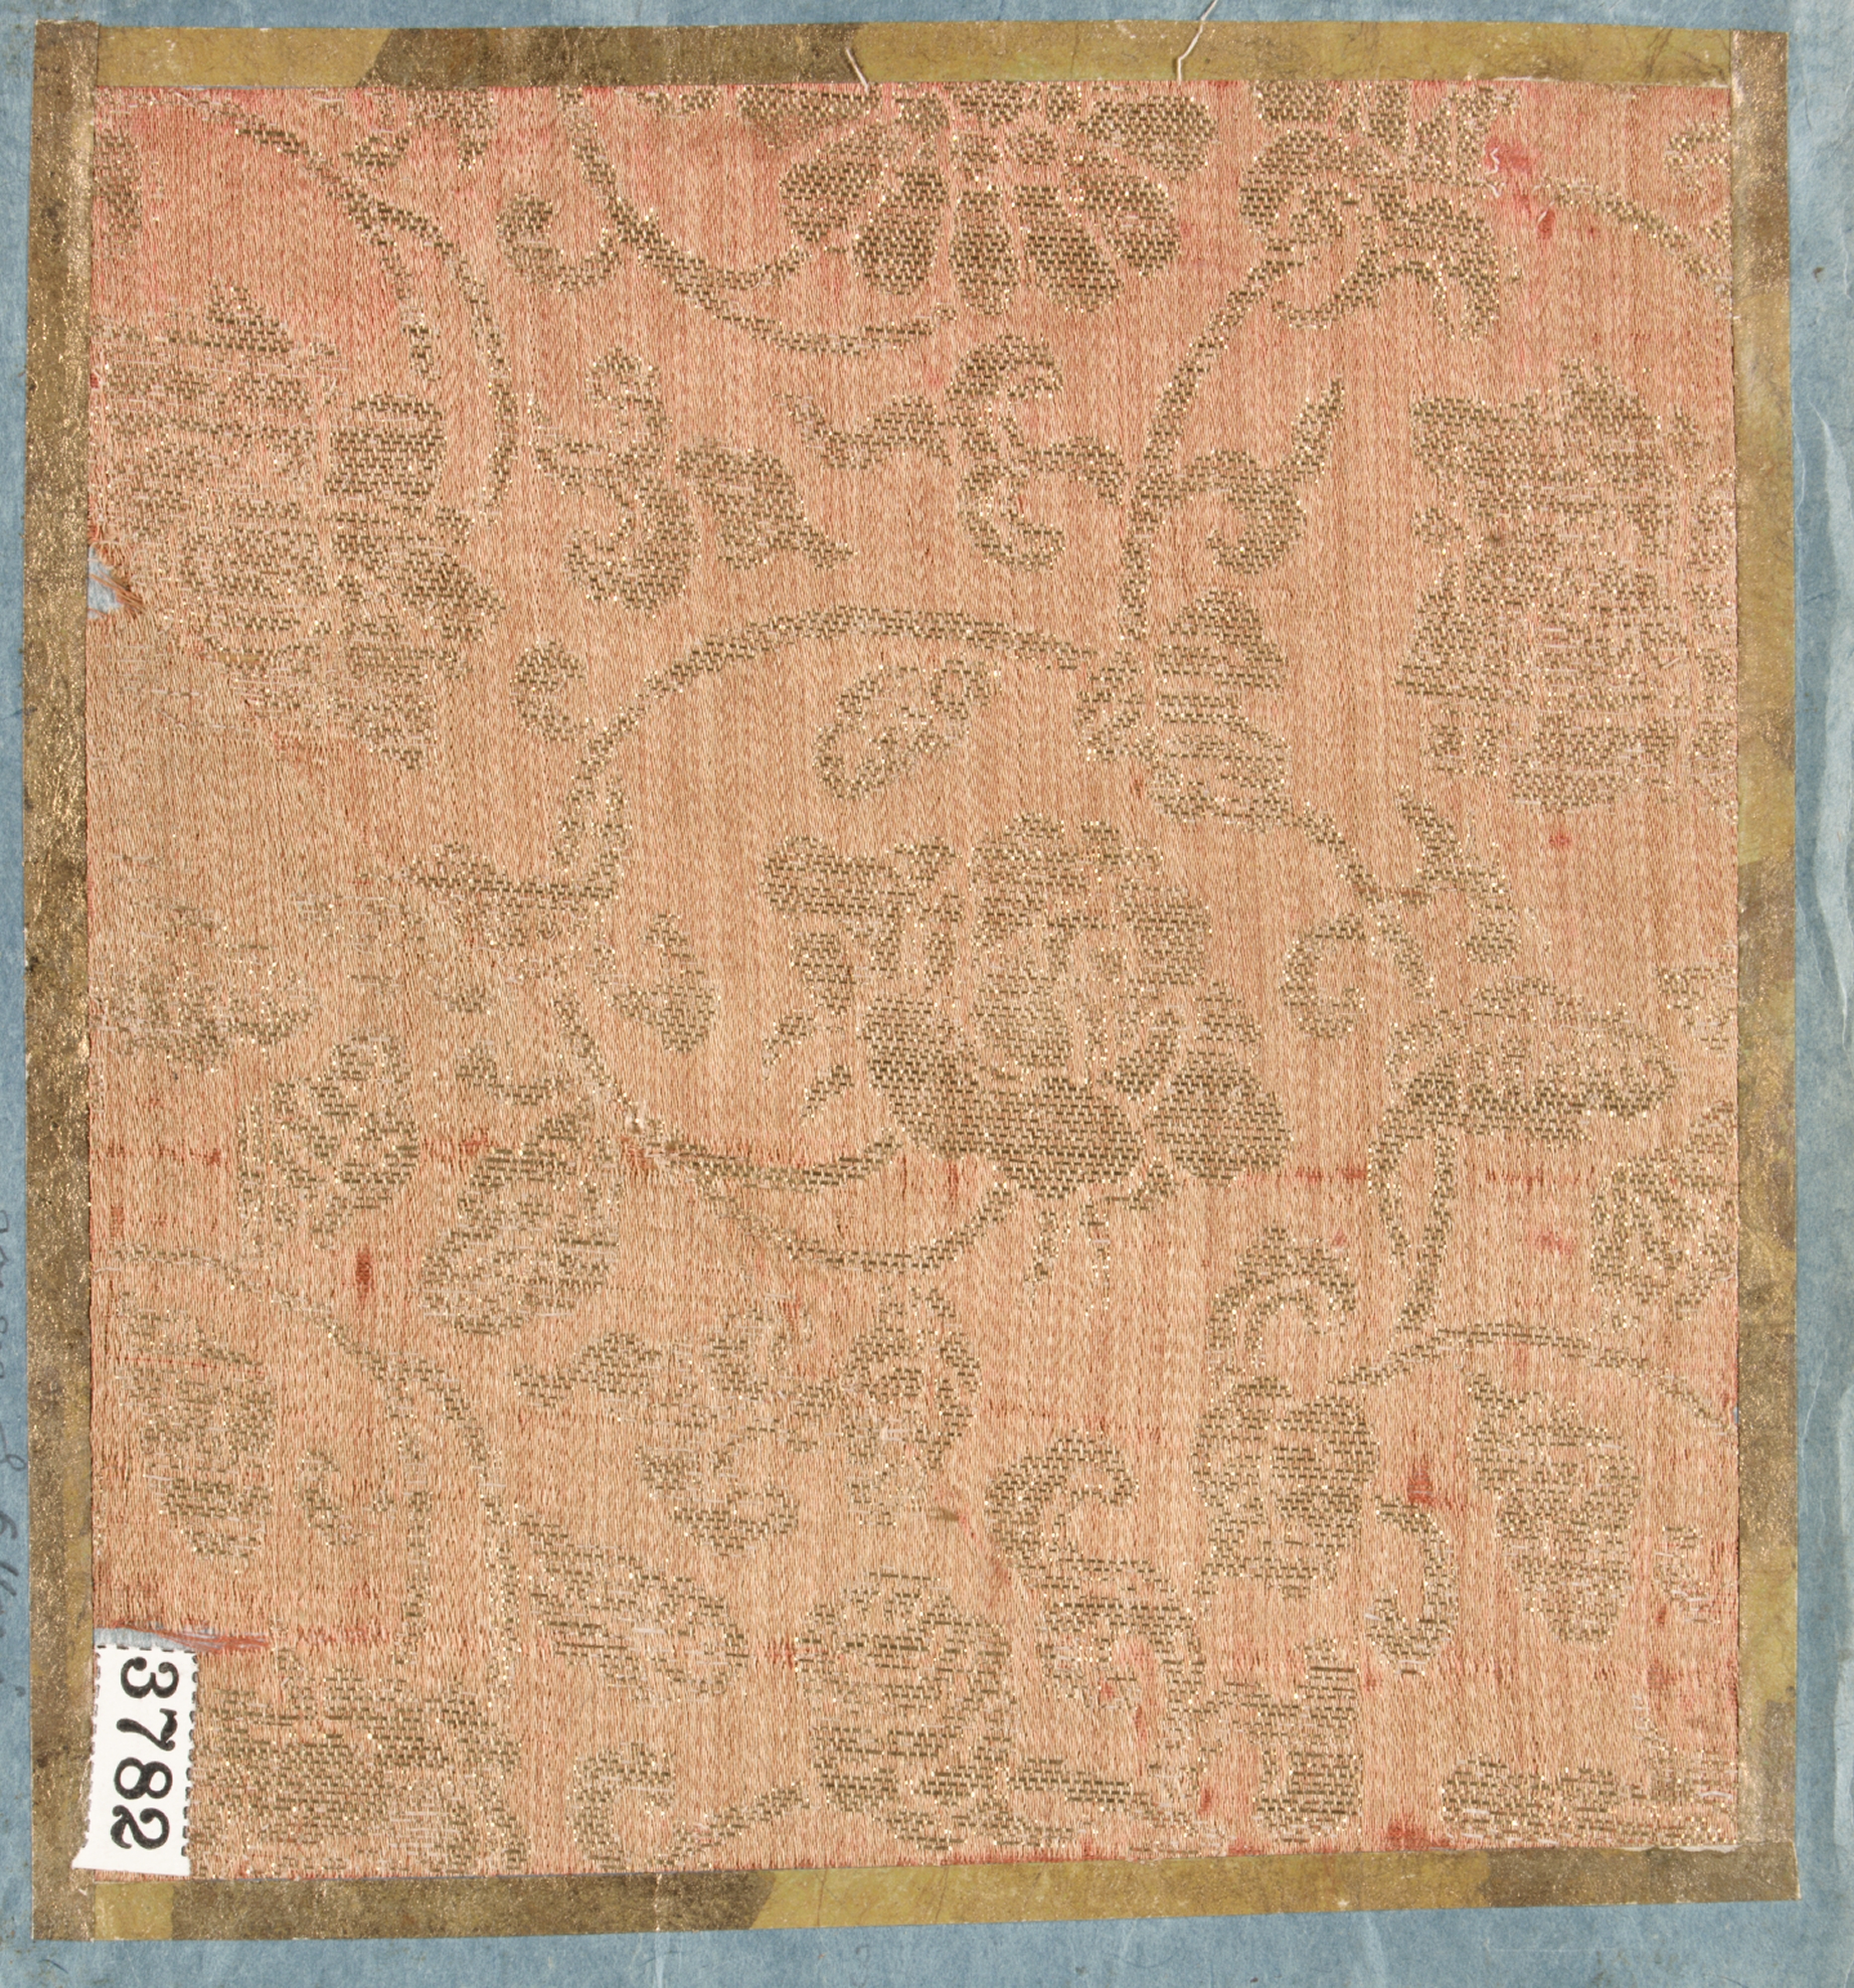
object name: sample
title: Textile Sample from Sample Book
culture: japanese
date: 1801-1900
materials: silk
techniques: tapestry